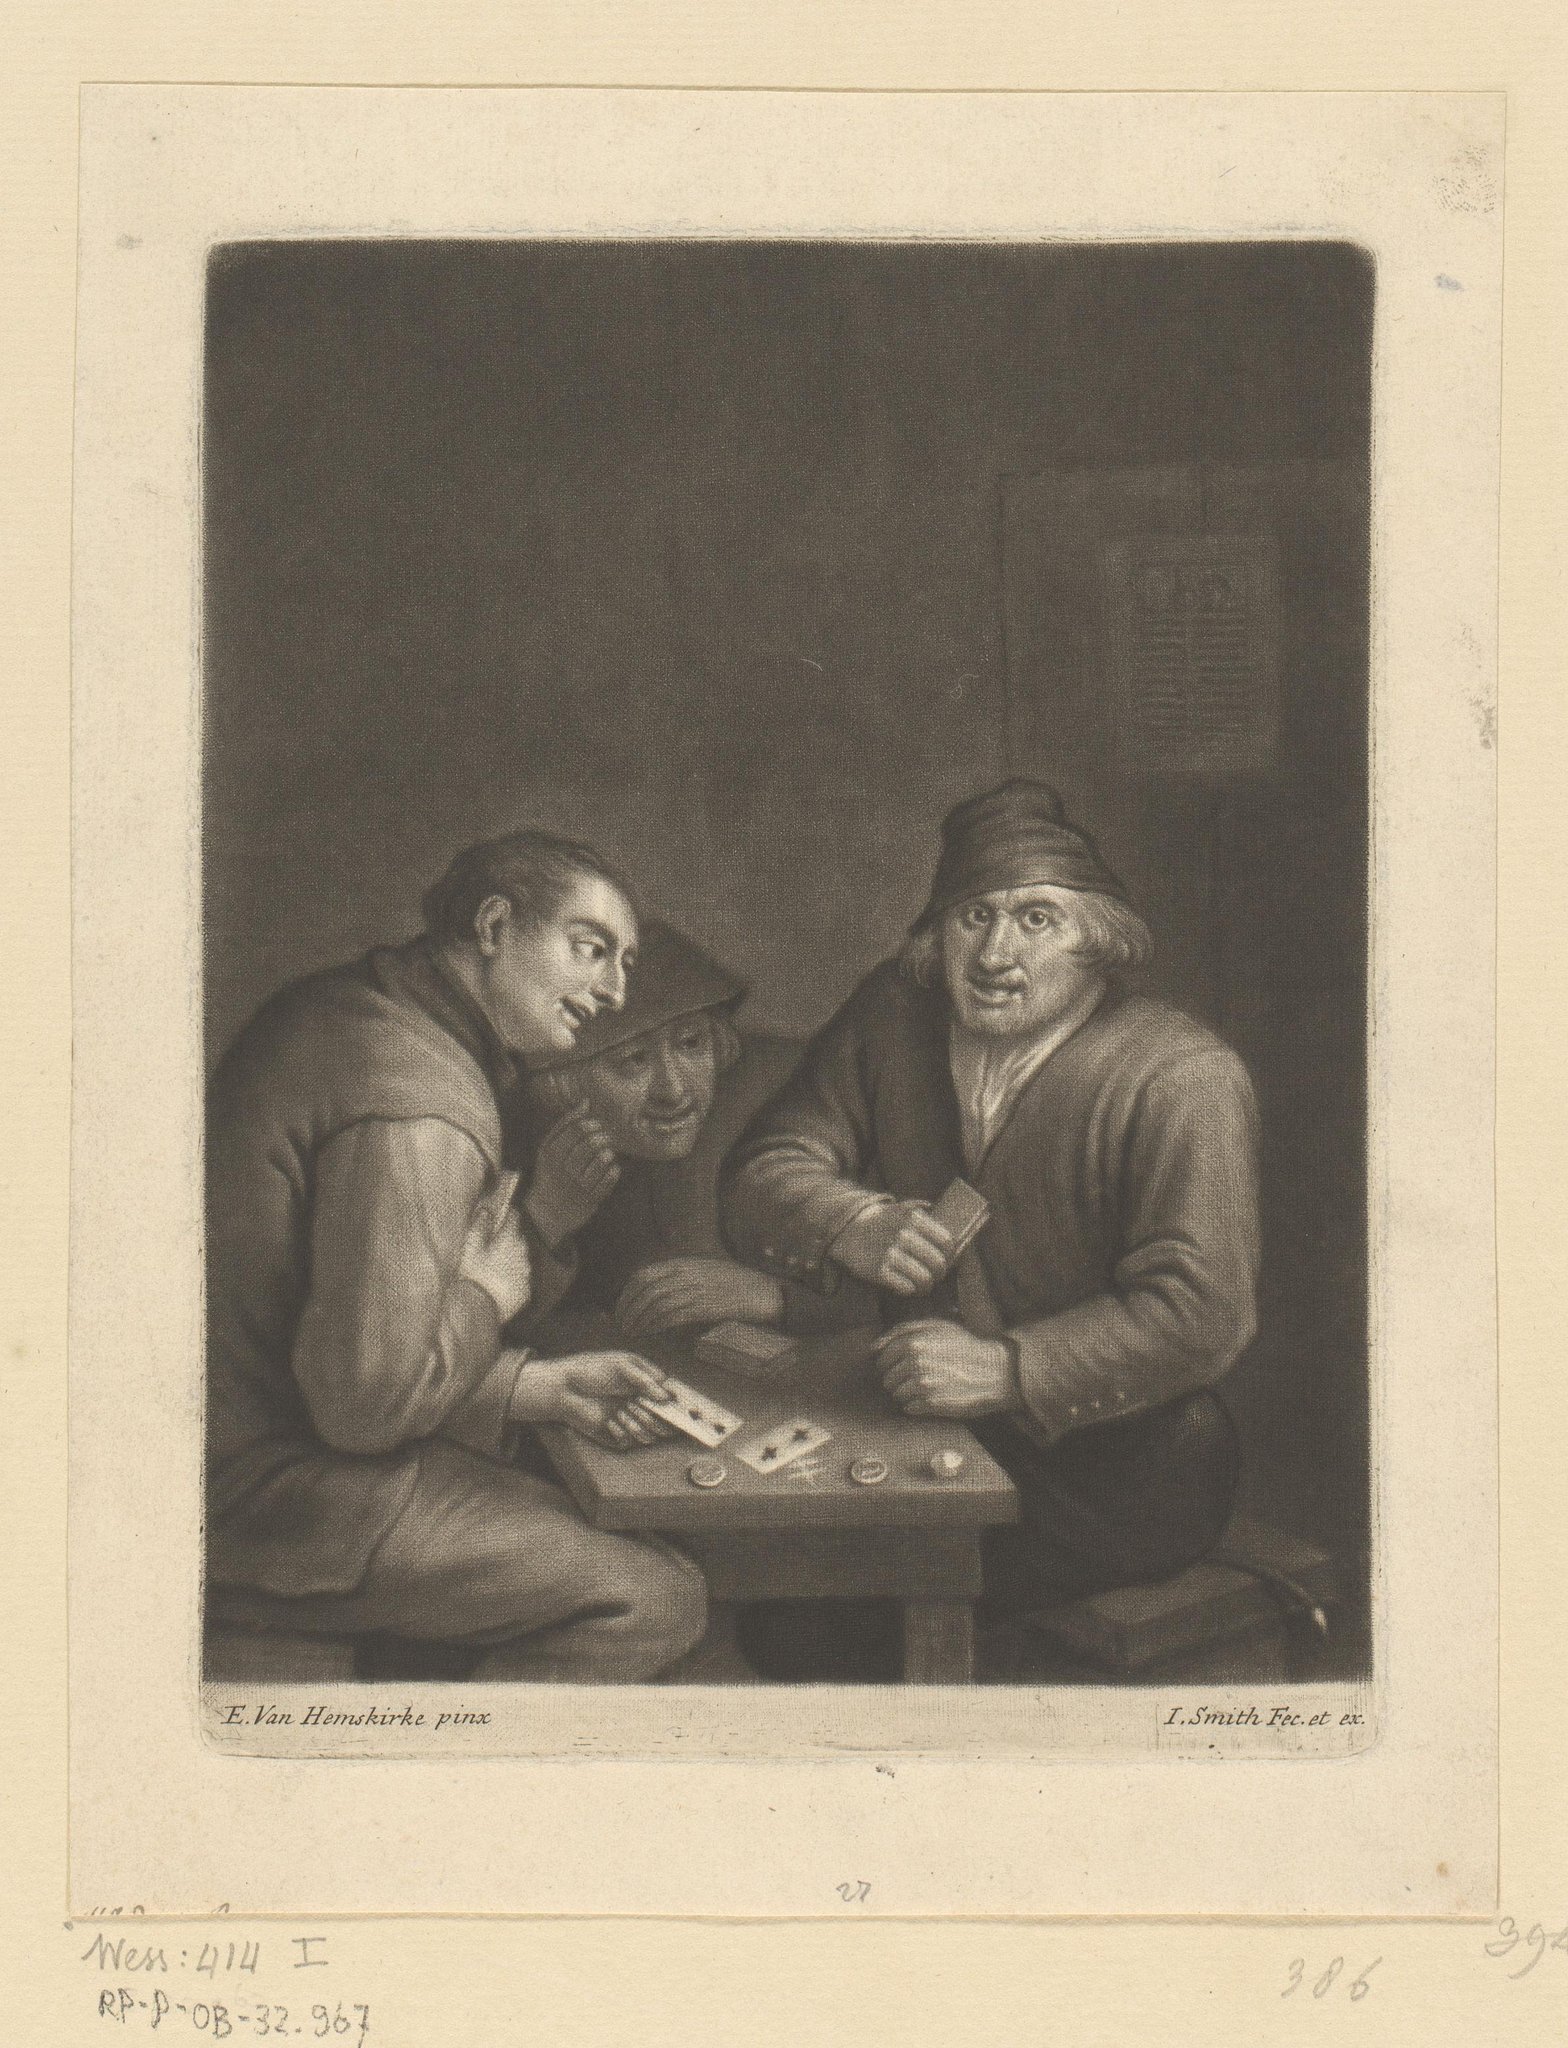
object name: print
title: Kaartspelers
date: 1662-1704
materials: paper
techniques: mezzotint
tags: adult man, card games (+ sportsman, player, etc.), hotel, hostelry, inn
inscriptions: collector's mark: Lugt 240